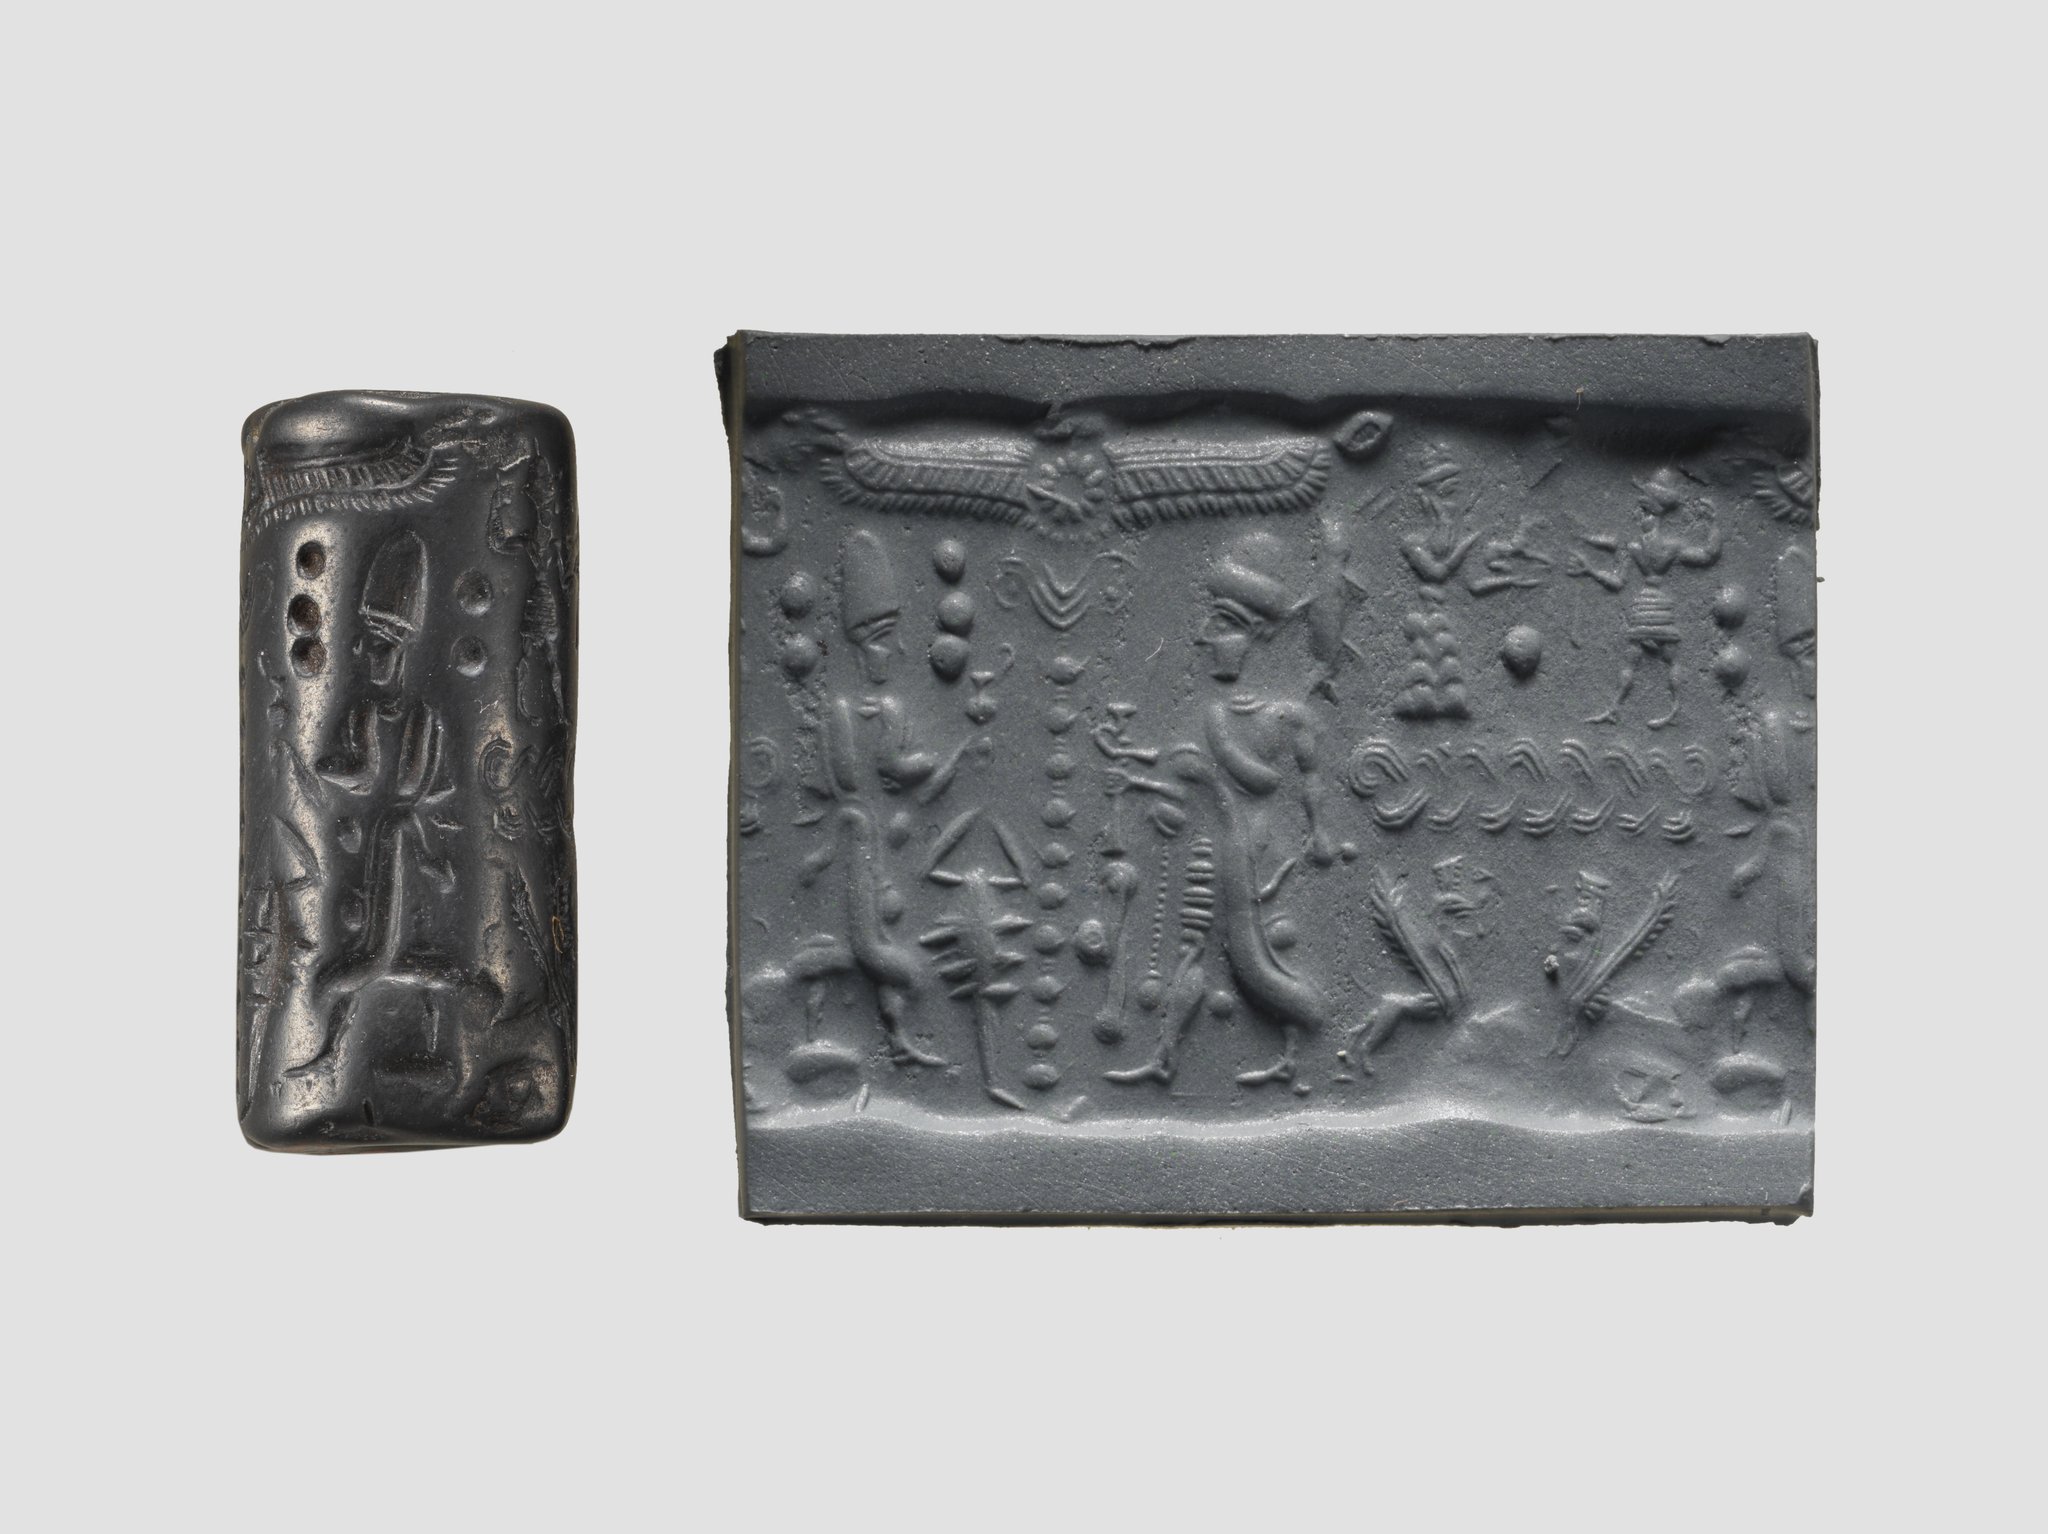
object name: cylinder seal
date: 1720-1650 BCE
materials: mineral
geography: syria